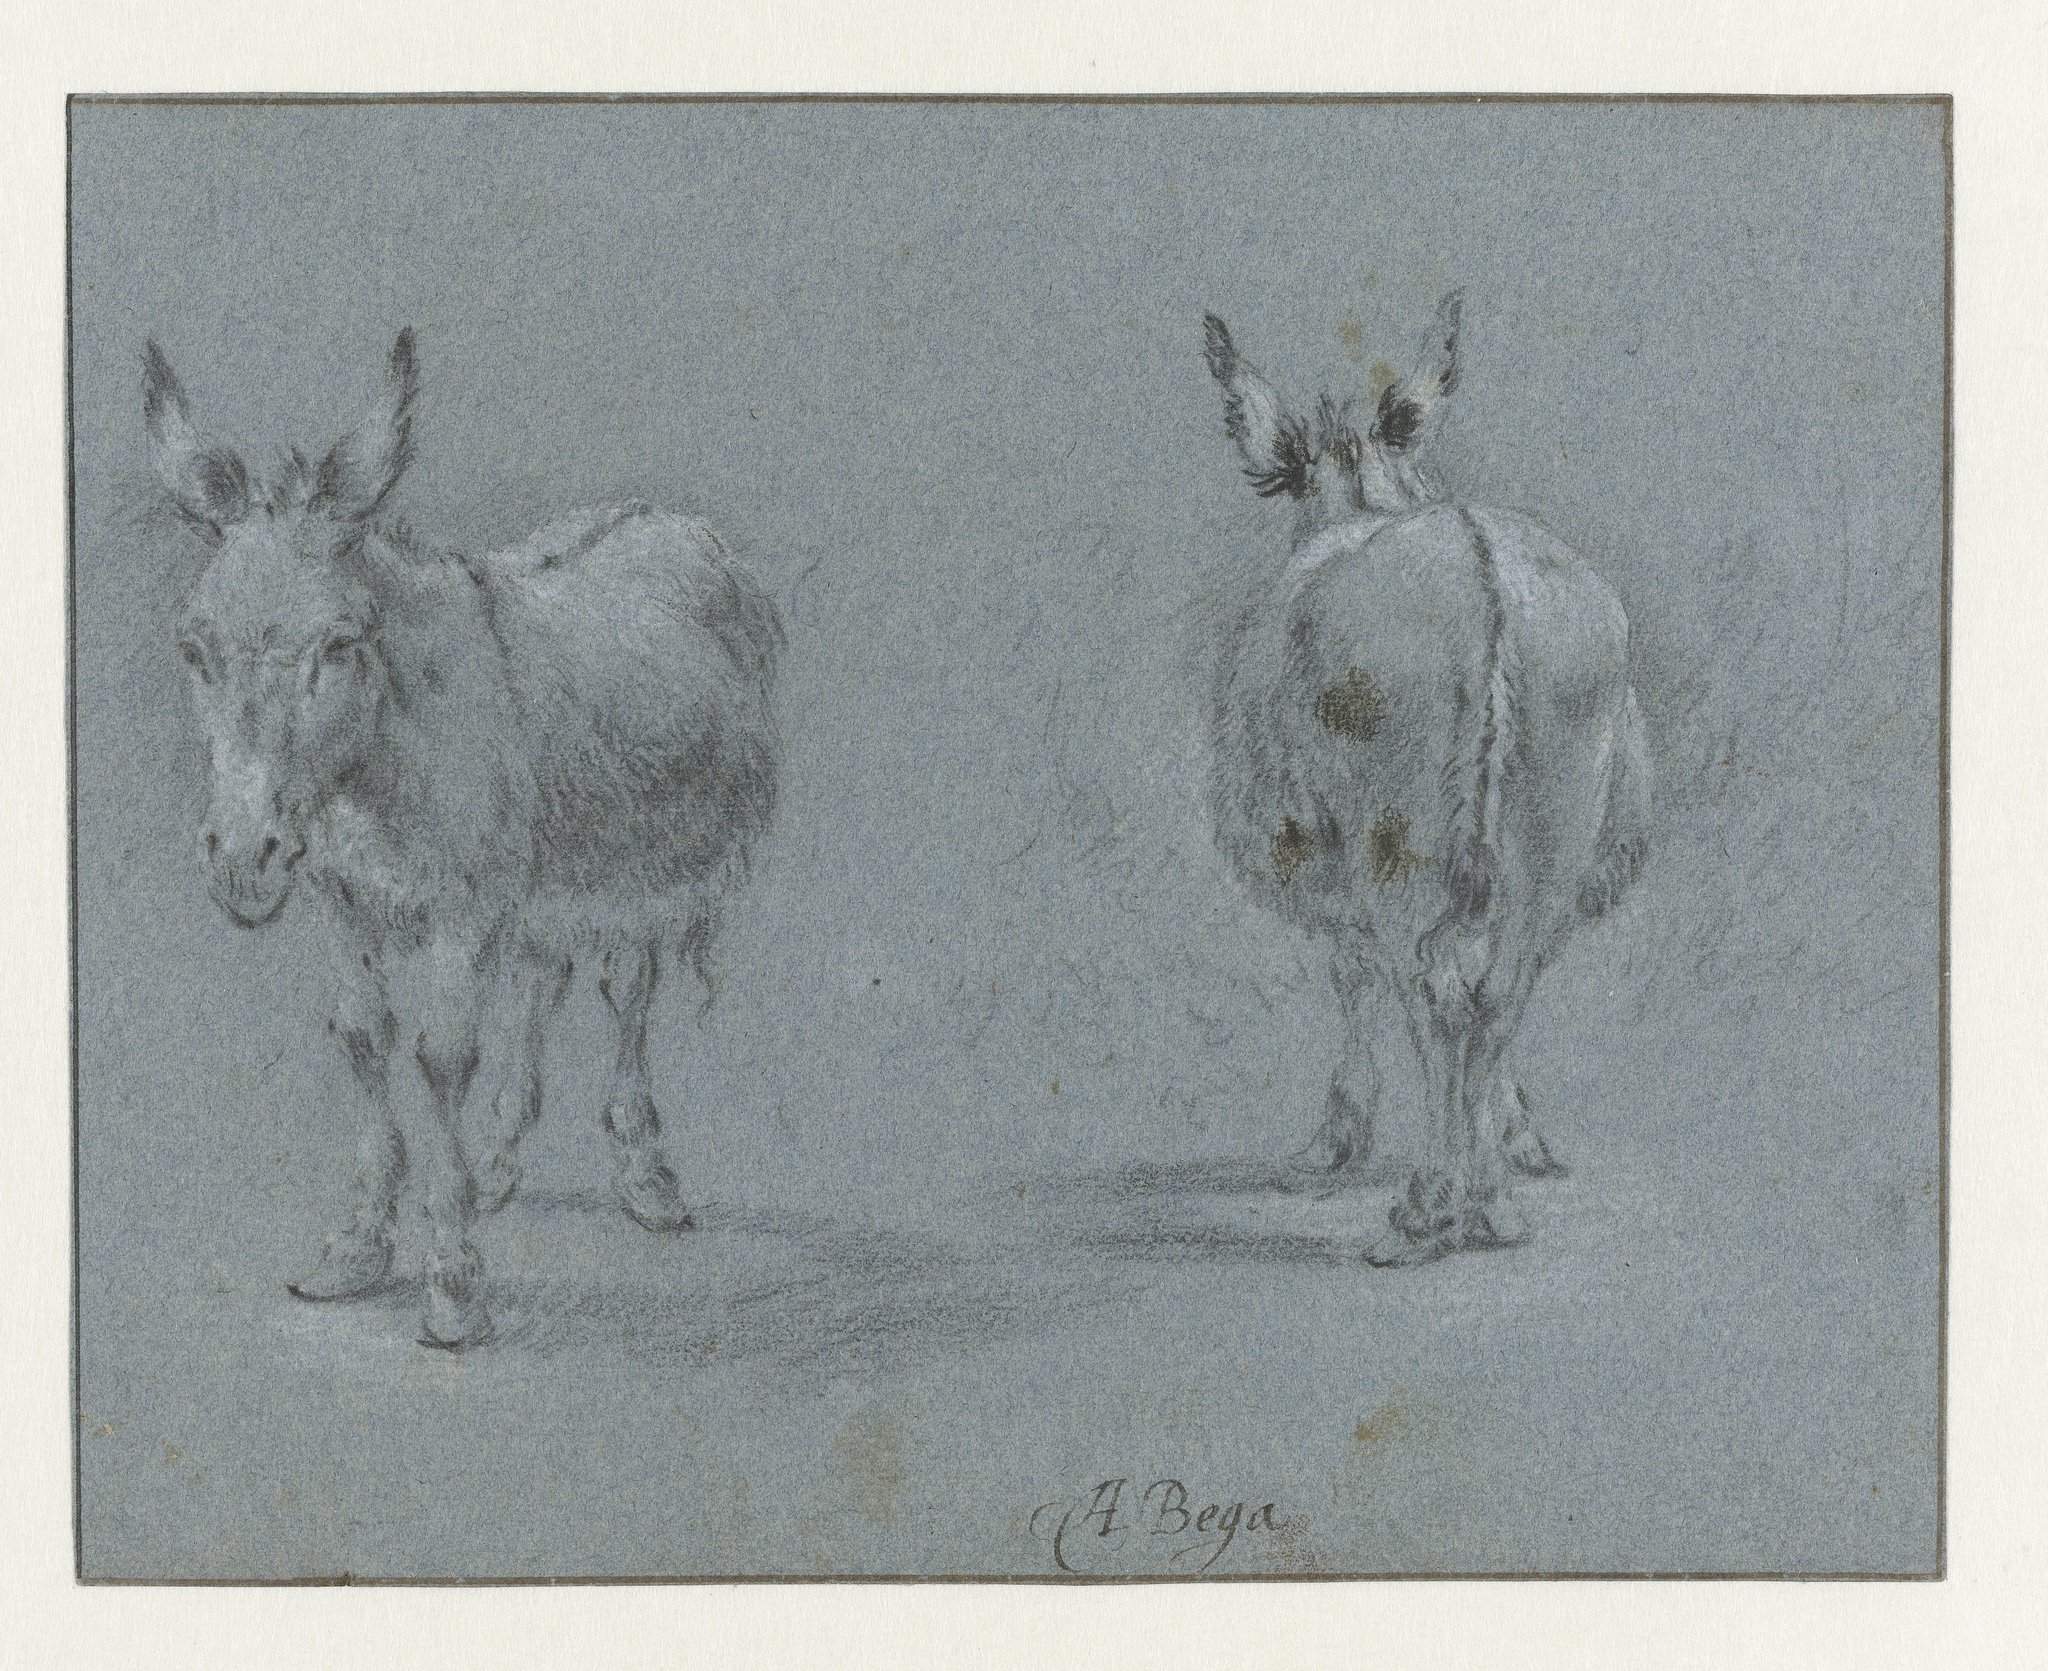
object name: drawing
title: Two Studies of a Donkey, Seen from the Front and Behind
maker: abraham jansz begeyn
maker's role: draughtsman, print maker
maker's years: 1637-1697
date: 1660-1665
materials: chalk, paper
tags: ass, donkey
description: Ezel, eenmaal van voren en eenmaal van achteren gezien.